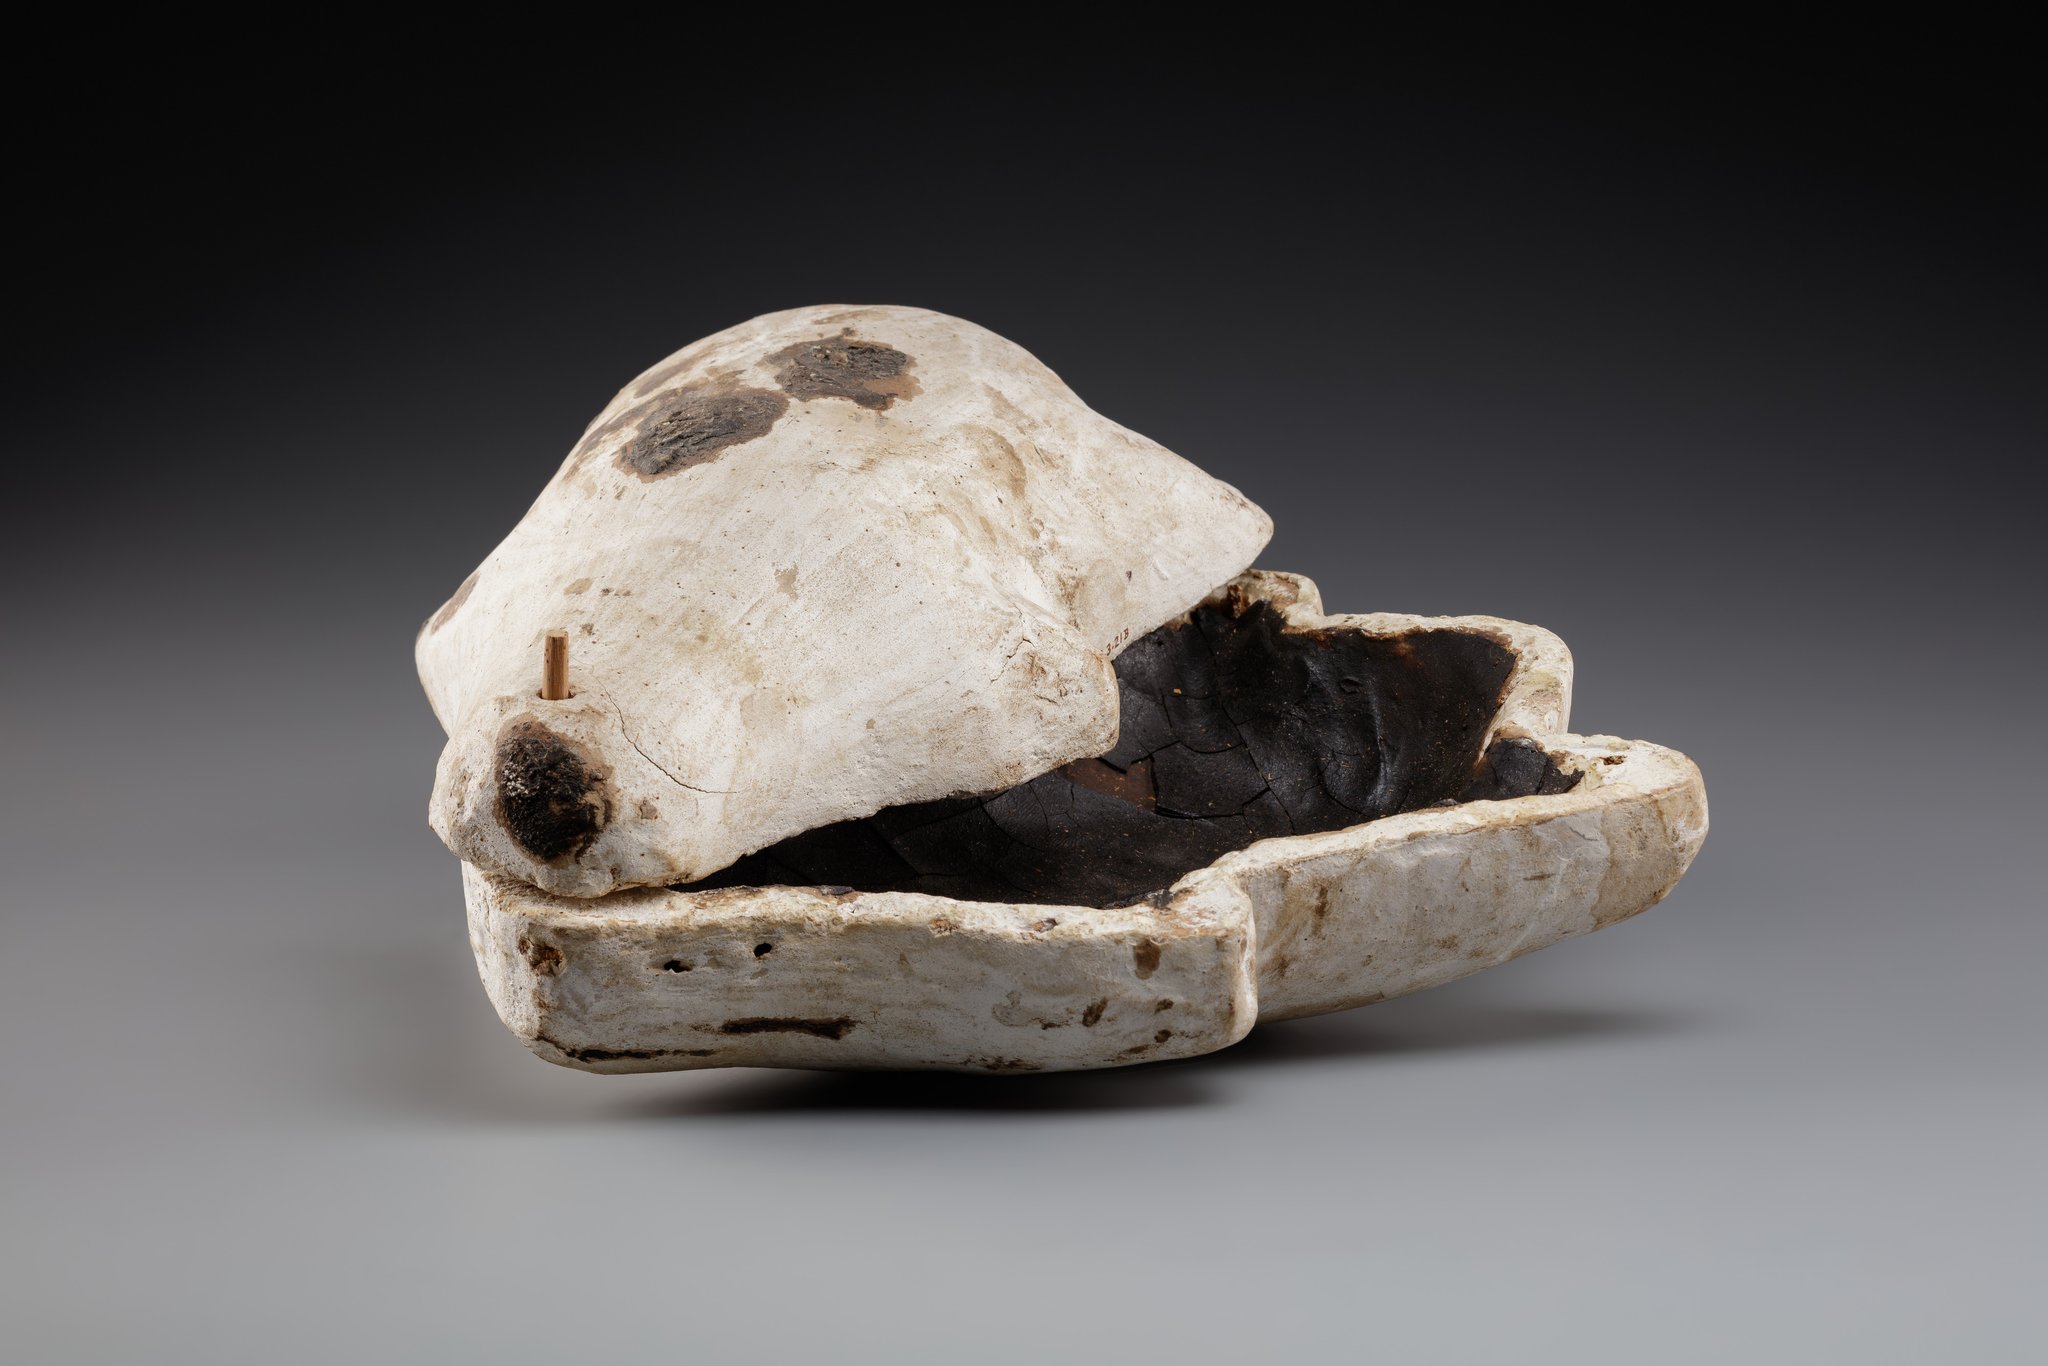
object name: mummified duck case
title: Container in the Shape of a Duck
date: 1525-1504 BCE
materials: plaster, wood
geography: egypt